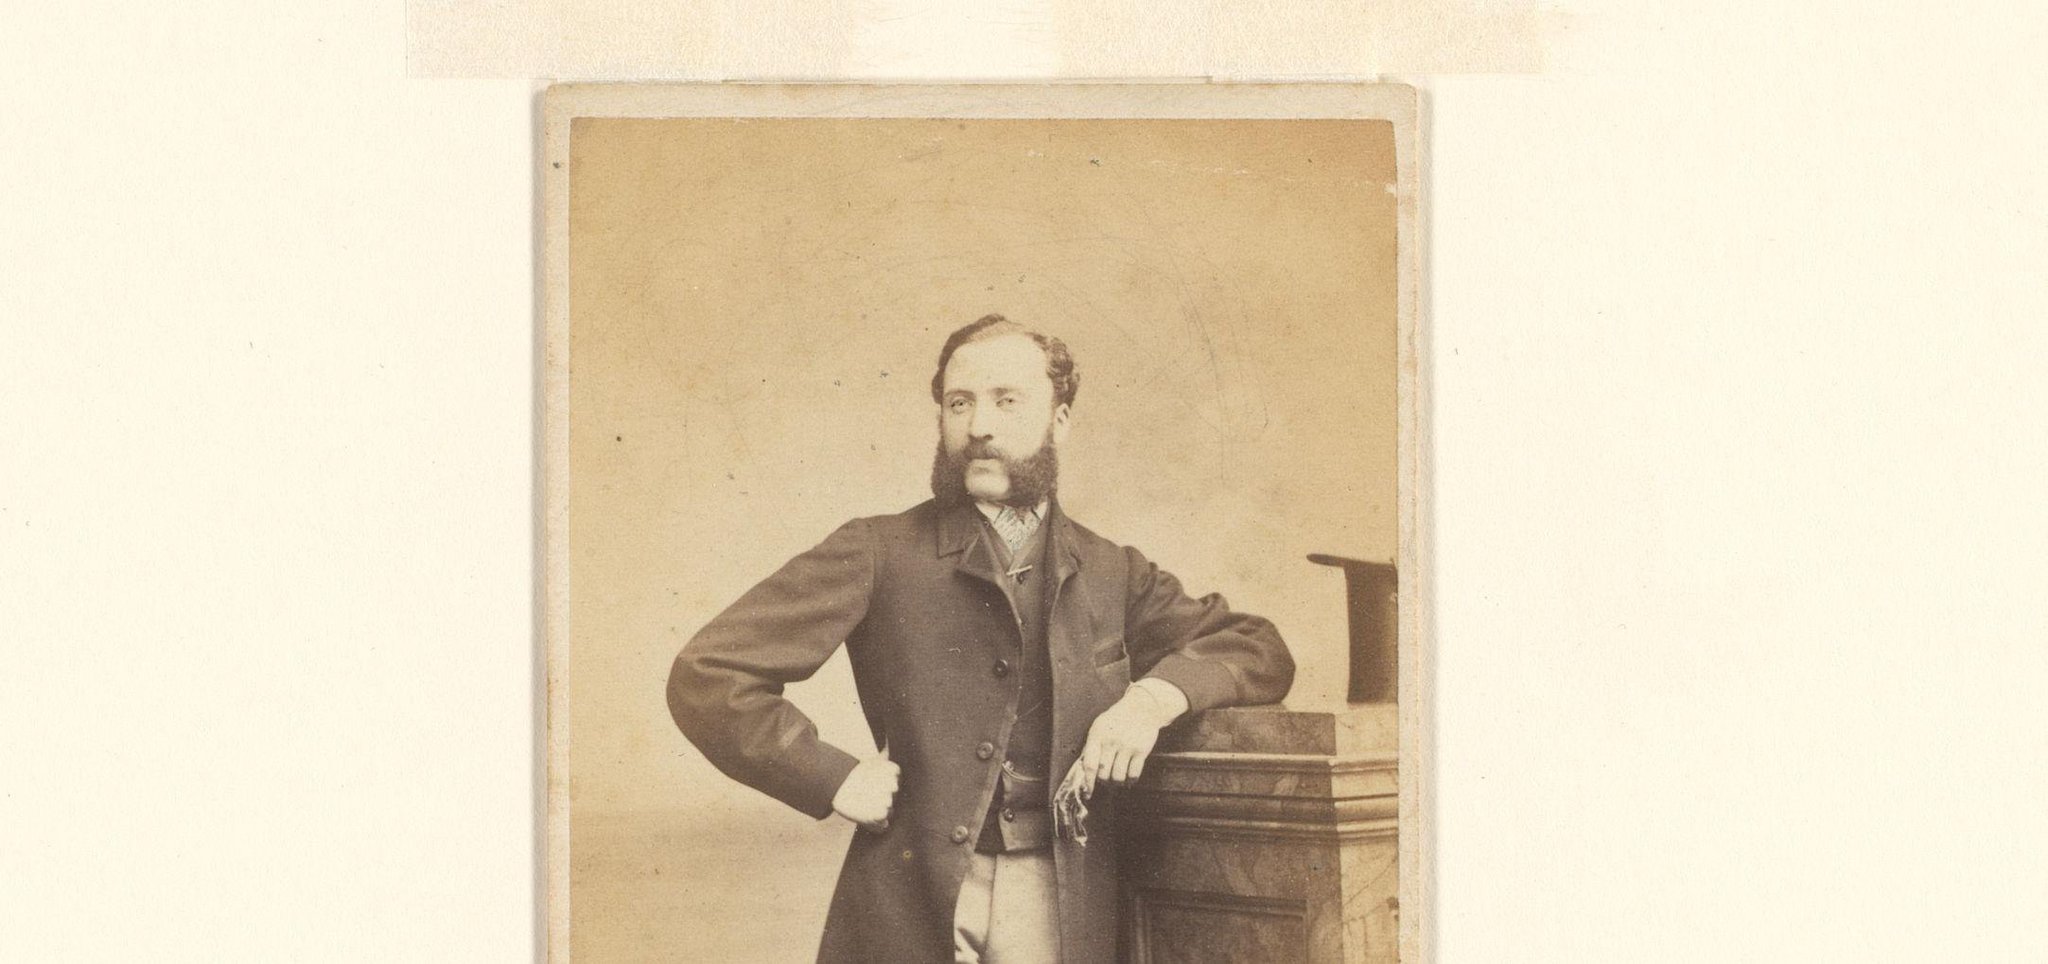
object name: photograph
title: Portret van een onbekend mannelijk lid van de familie Asser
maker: louis wegner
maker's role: print maker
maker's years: 1816-1864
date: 1857-1864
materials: cardboard, paper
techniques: albumen print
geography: amsterdam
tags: adult man, anonymous historical person portrayed, amsterdam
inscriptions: address: ‘Prinsengracht BB 439/ AMSTERDAM’